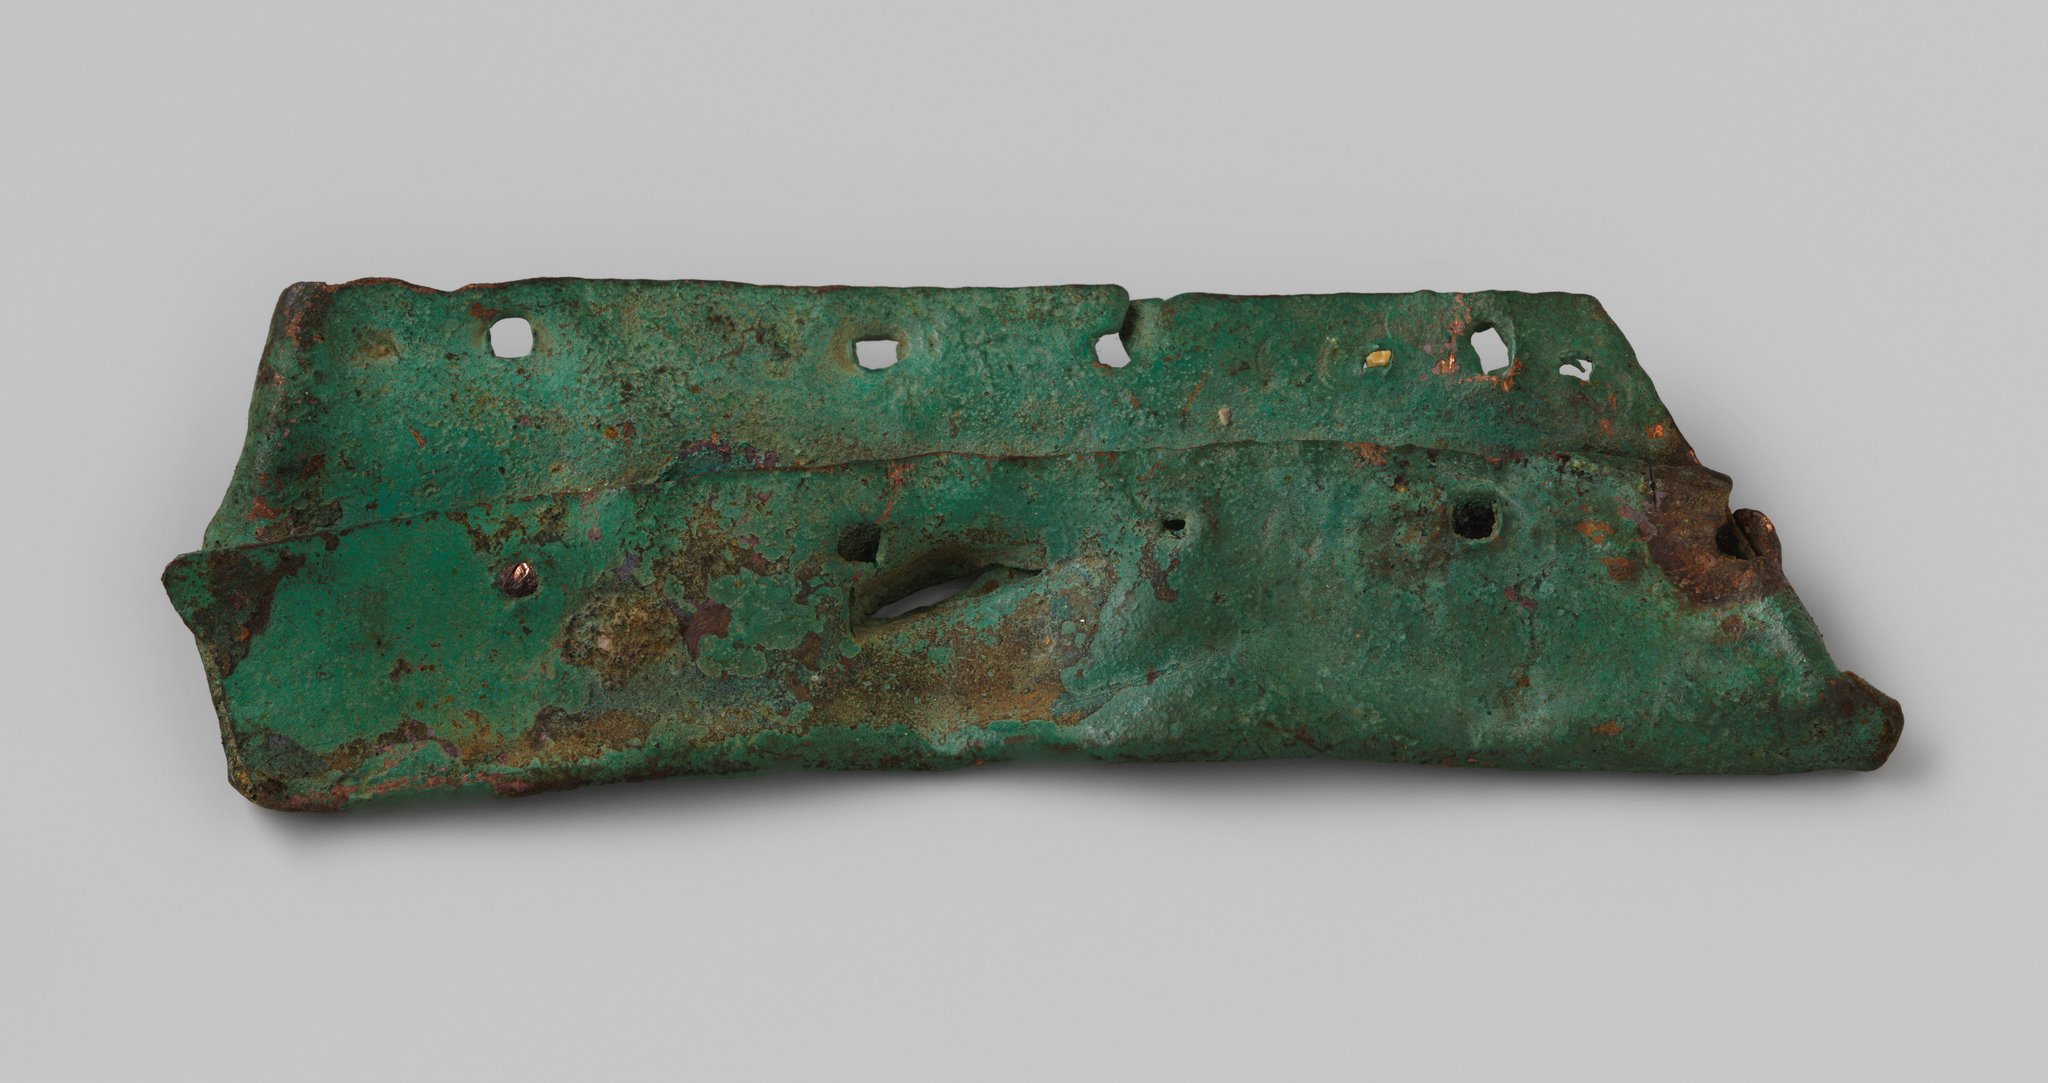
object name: fragment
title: Fragment koperen plaatwerk uit het wrak van de Oost-Indiëvaarder Hollandia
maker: Anonymous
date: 1700-1743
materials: copper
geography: netherlands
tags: verenigde oostindische compagnie, hollandia (schip), annet